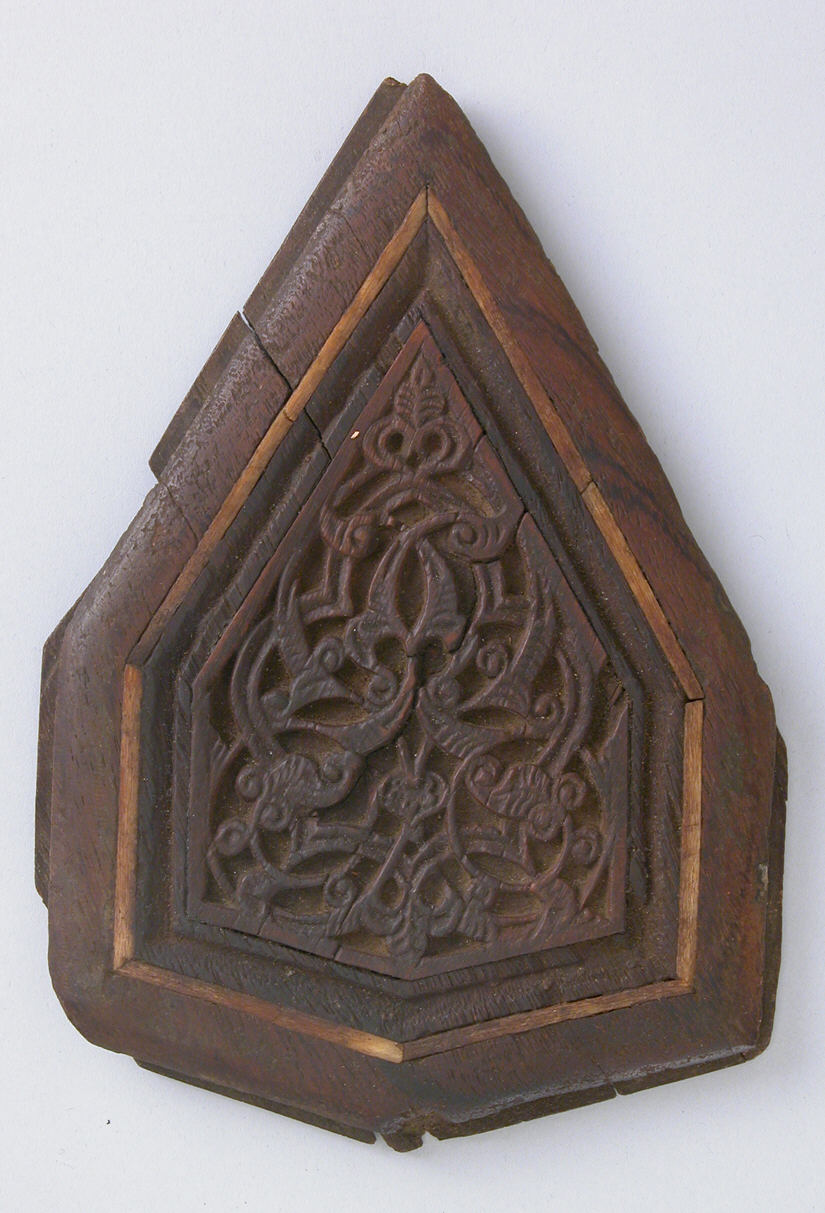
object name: panel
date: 1201-1400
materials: bone, ivory, wood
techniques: carving, inlay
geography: egypt